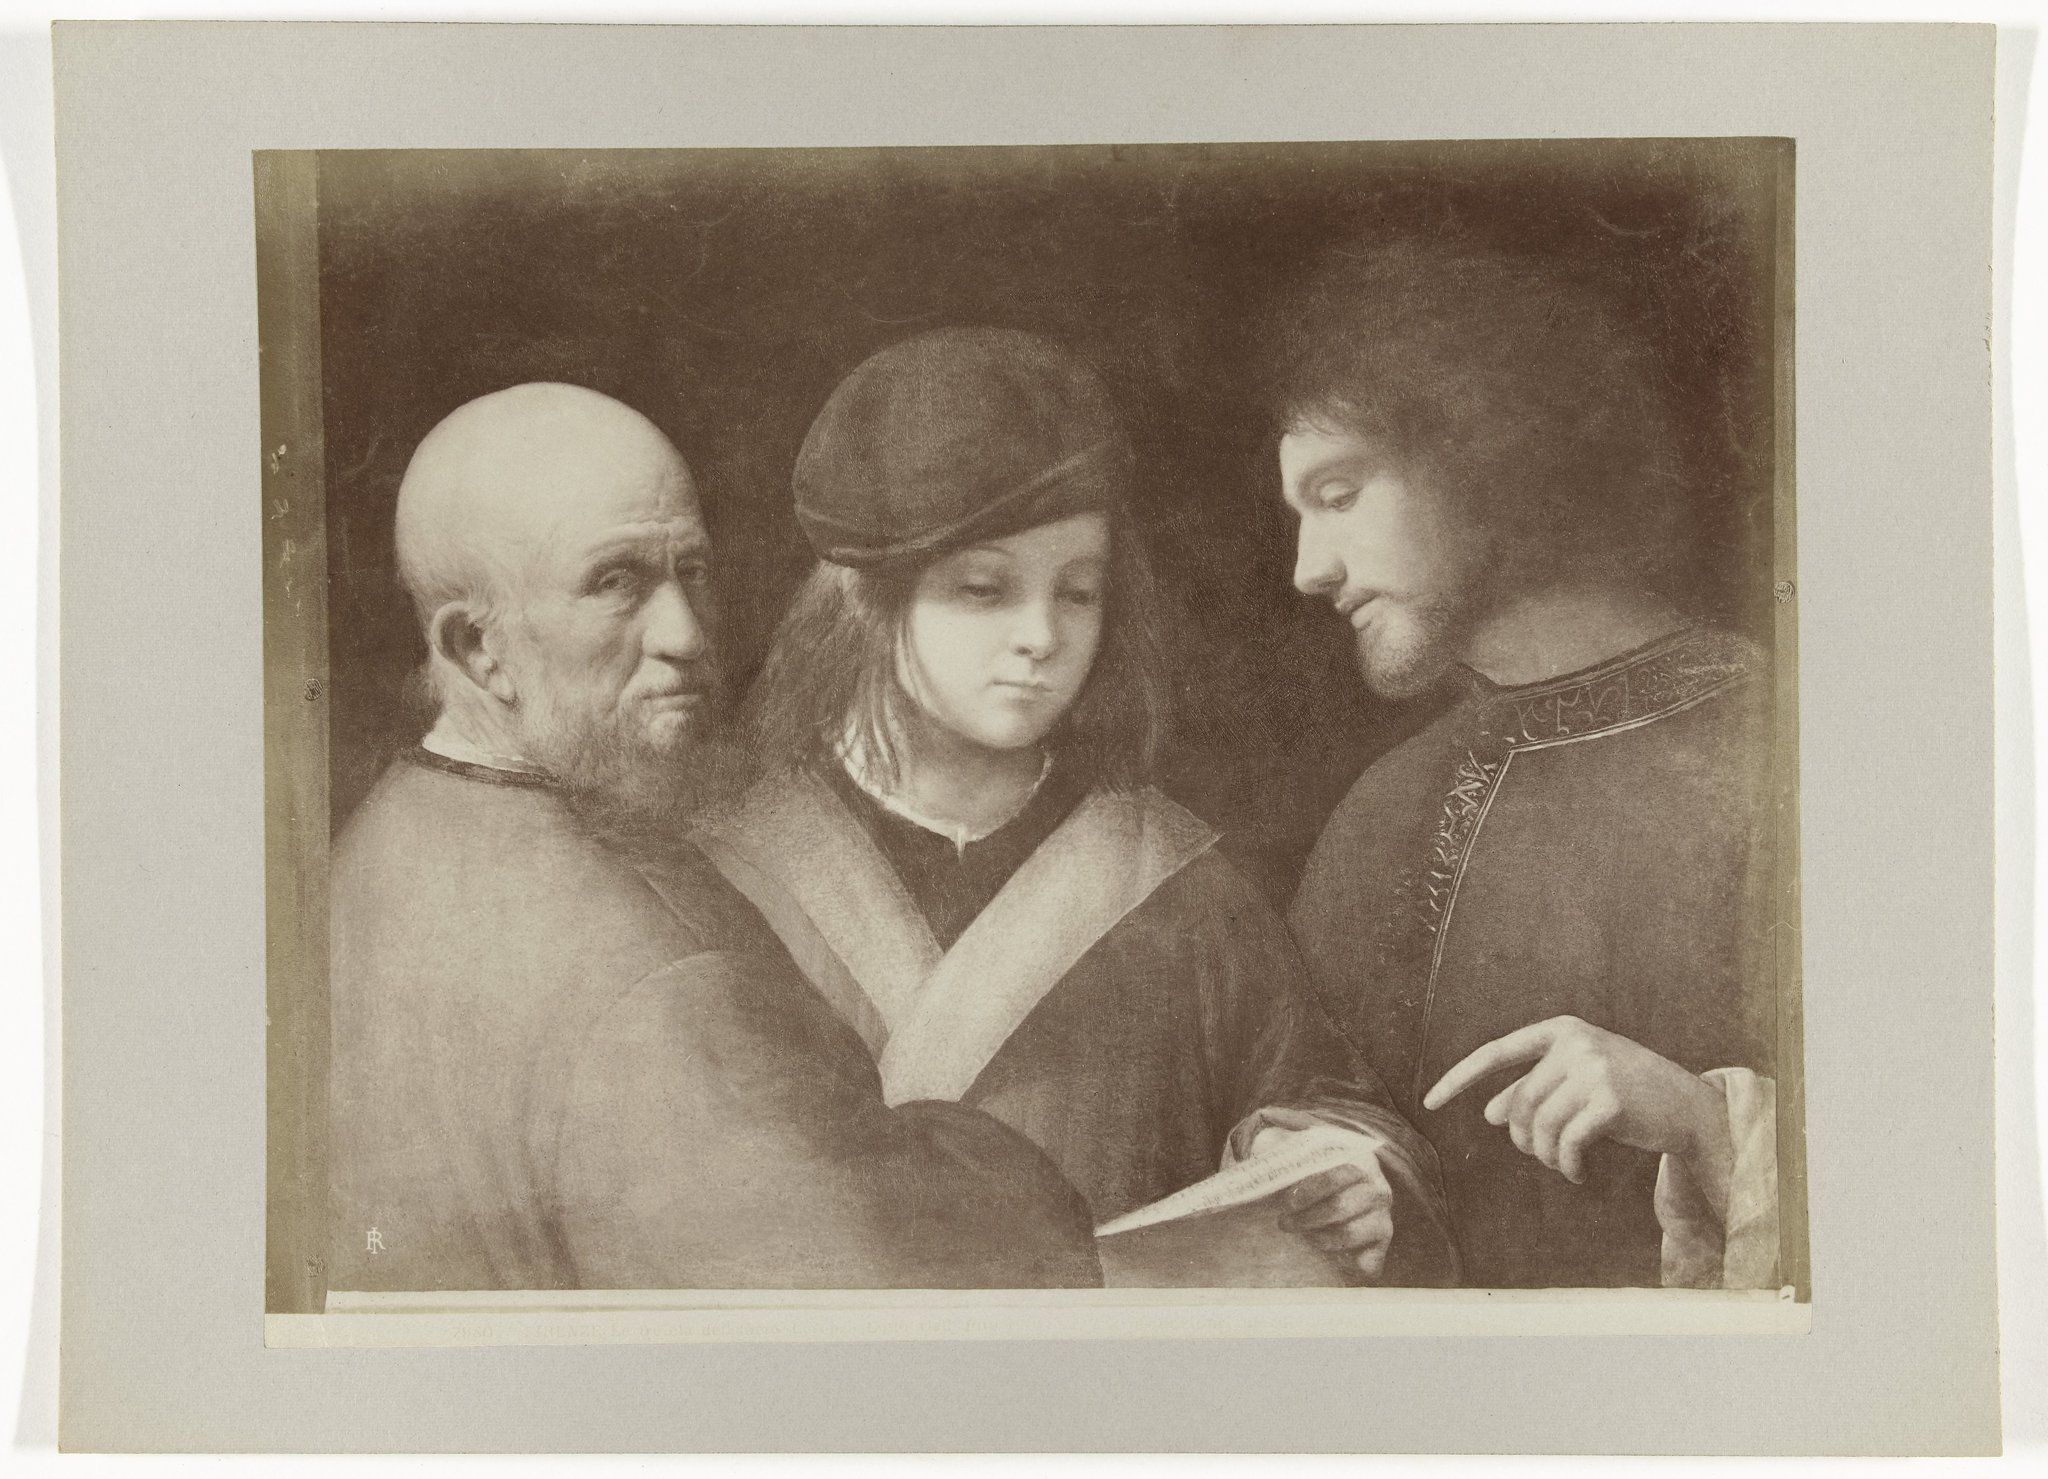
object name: photograph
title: Schilderij met drie mannen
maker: Anonymous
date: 1880-1904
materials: cardboard, paper, photographic support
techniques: albumen print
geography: florence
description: Drie mannen, de middelste heeft een brief vast. Linksonder op het schilderij staat het monogram IR.